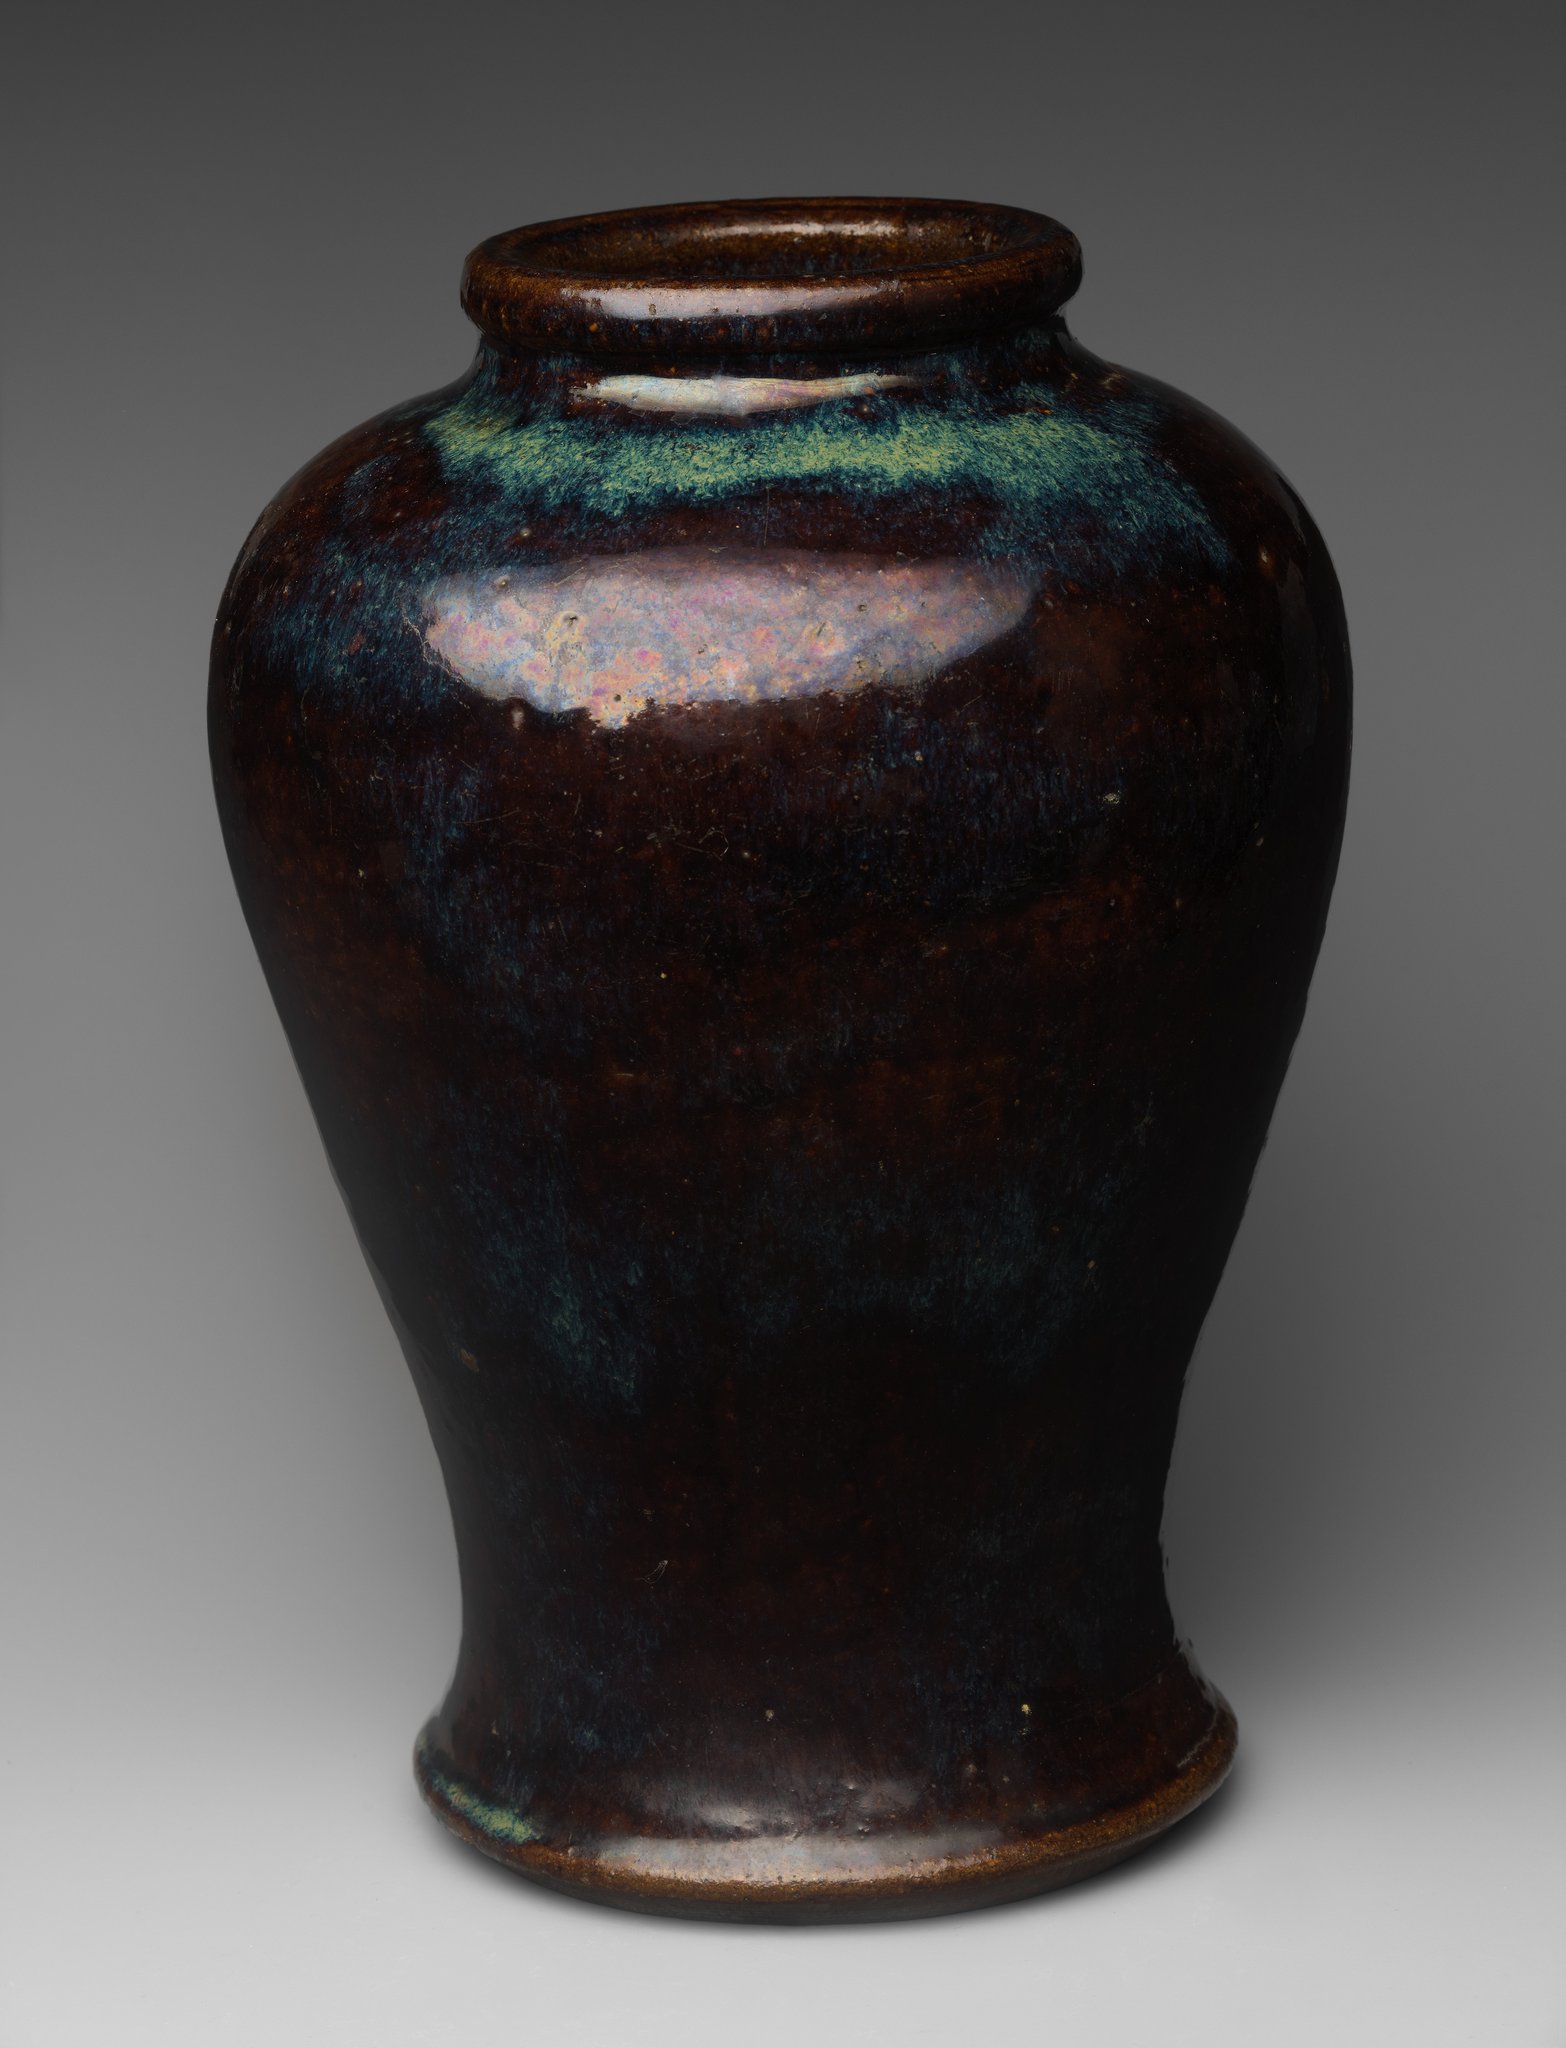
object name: vase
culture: japanese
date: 1701-1800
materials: clay, glaze